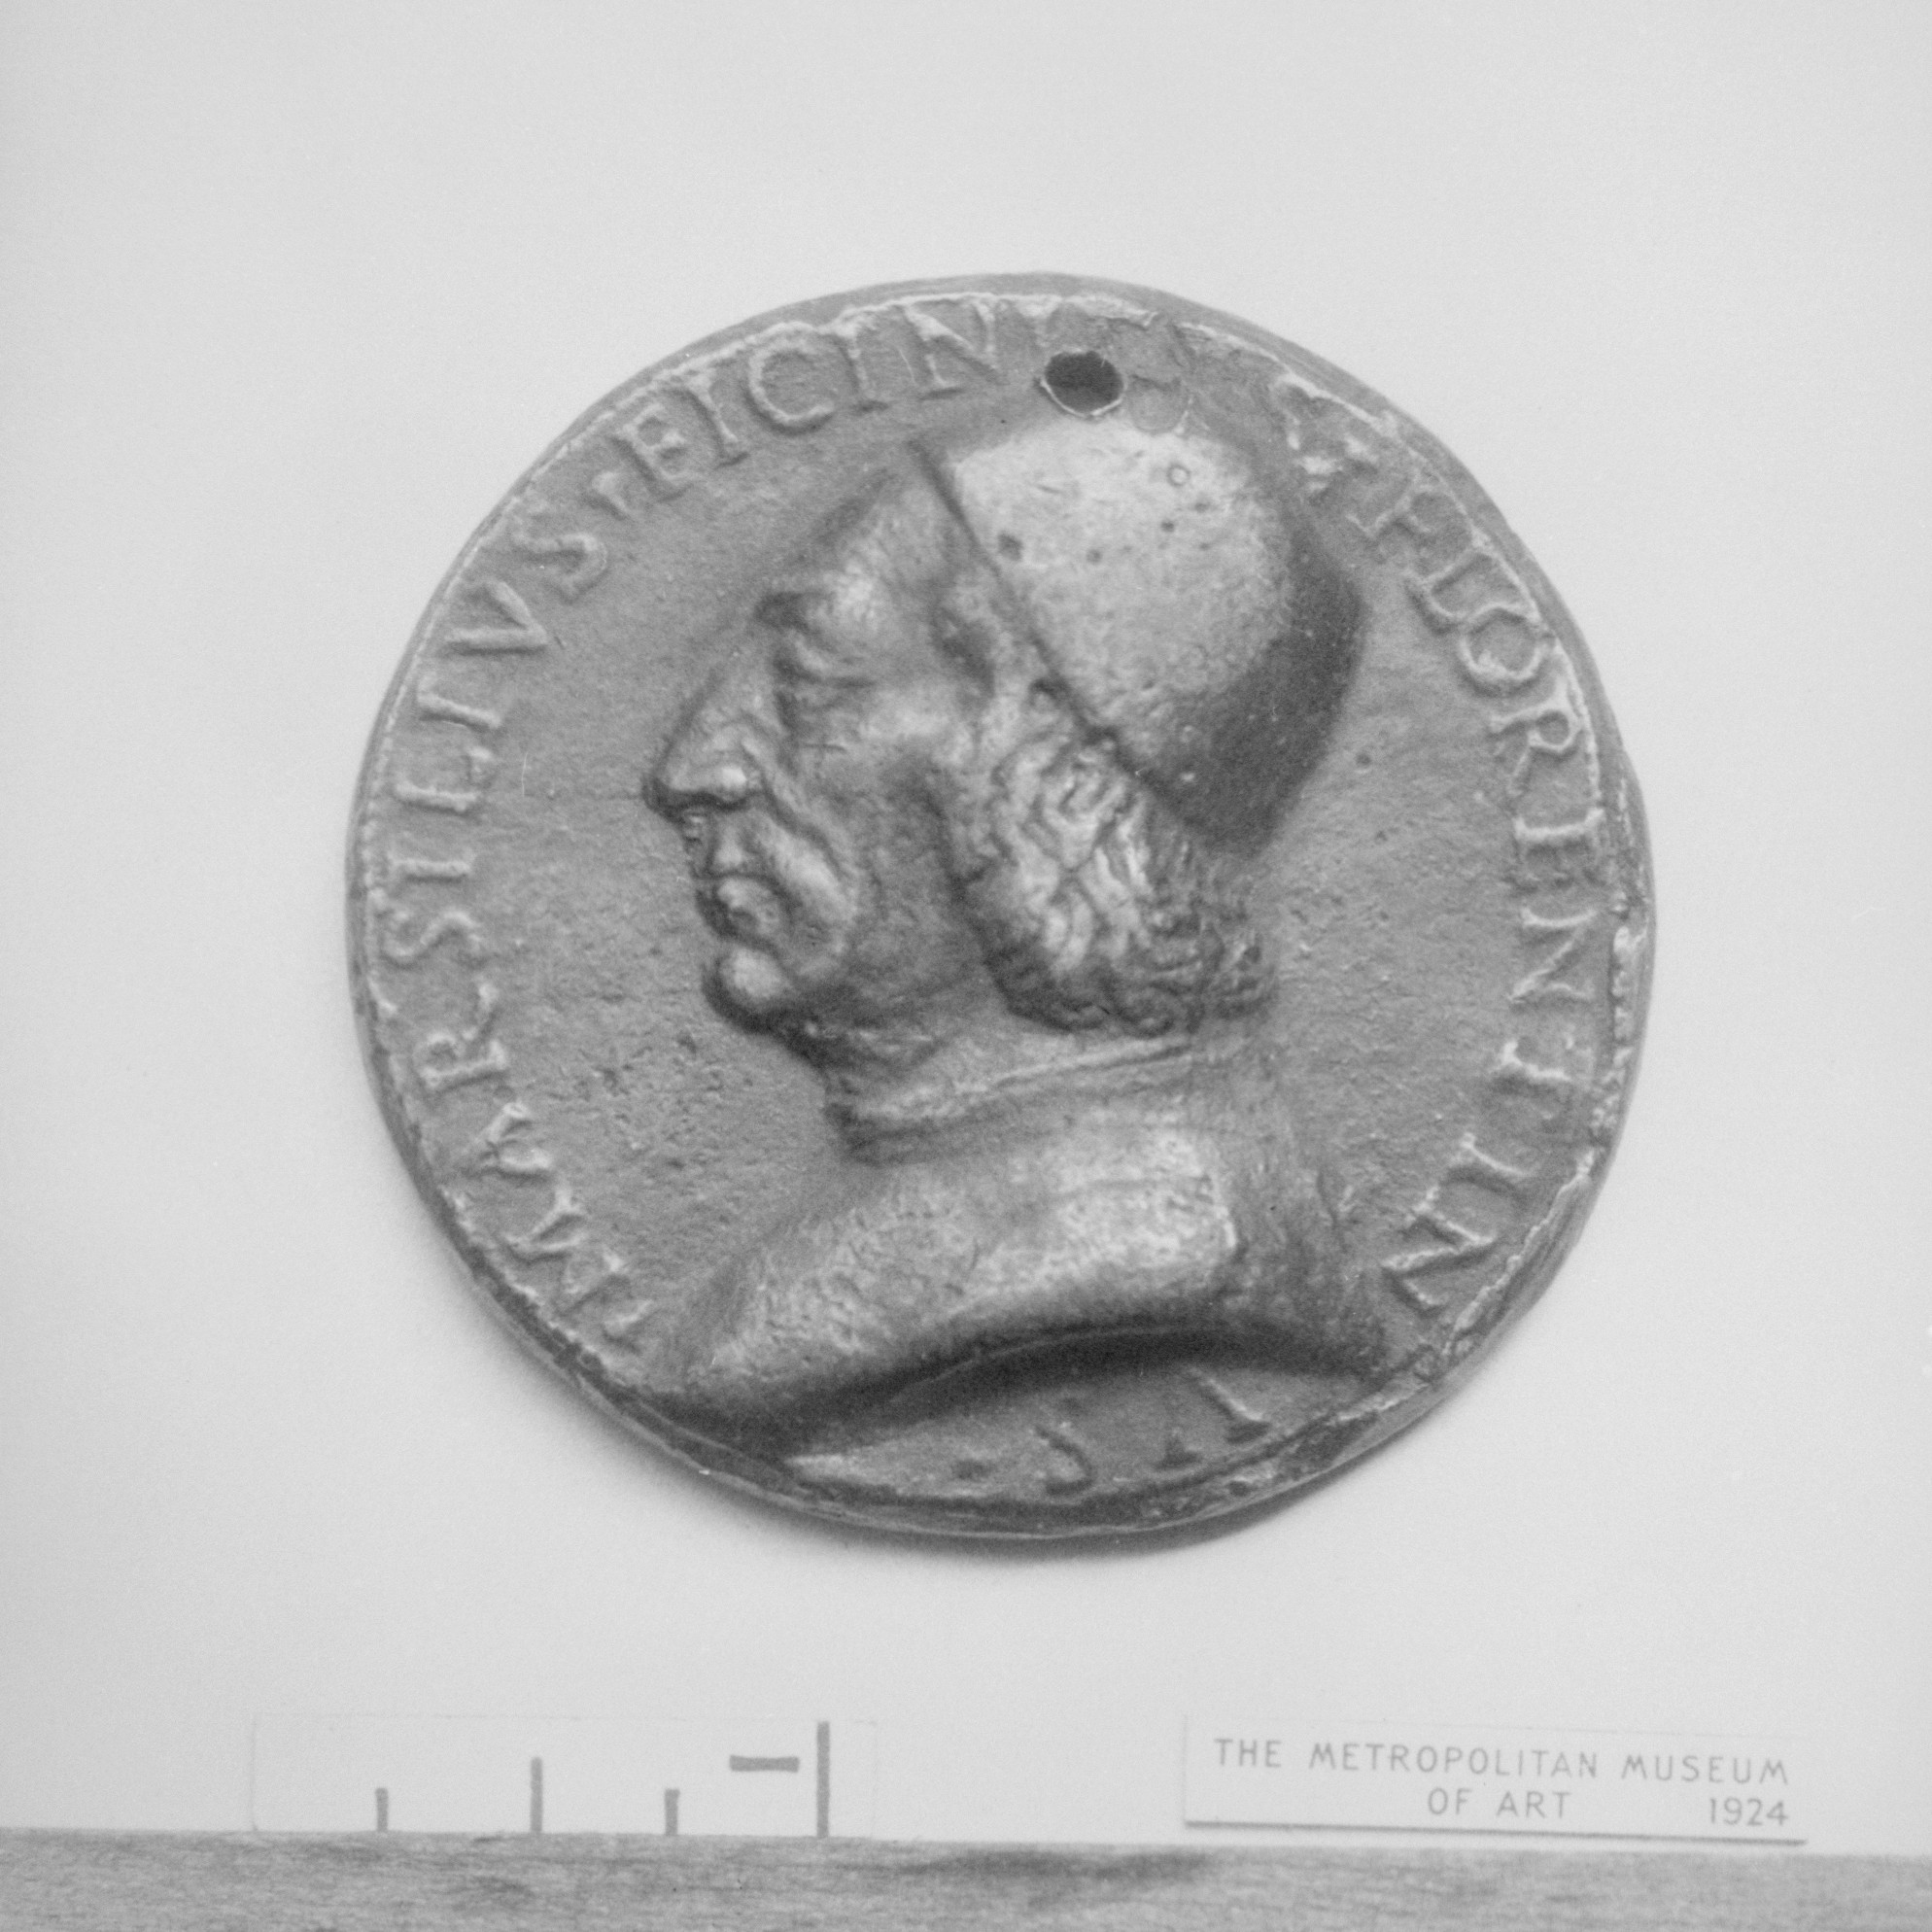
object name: medal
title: Marsilio Ficino (1433–1499)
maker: niccolò fiorentino (niccolò di forzore spinelli)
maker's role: maker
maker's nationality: italian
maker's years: 1430-1514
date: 1490-1499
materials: bronze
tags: men,profiles,snakes